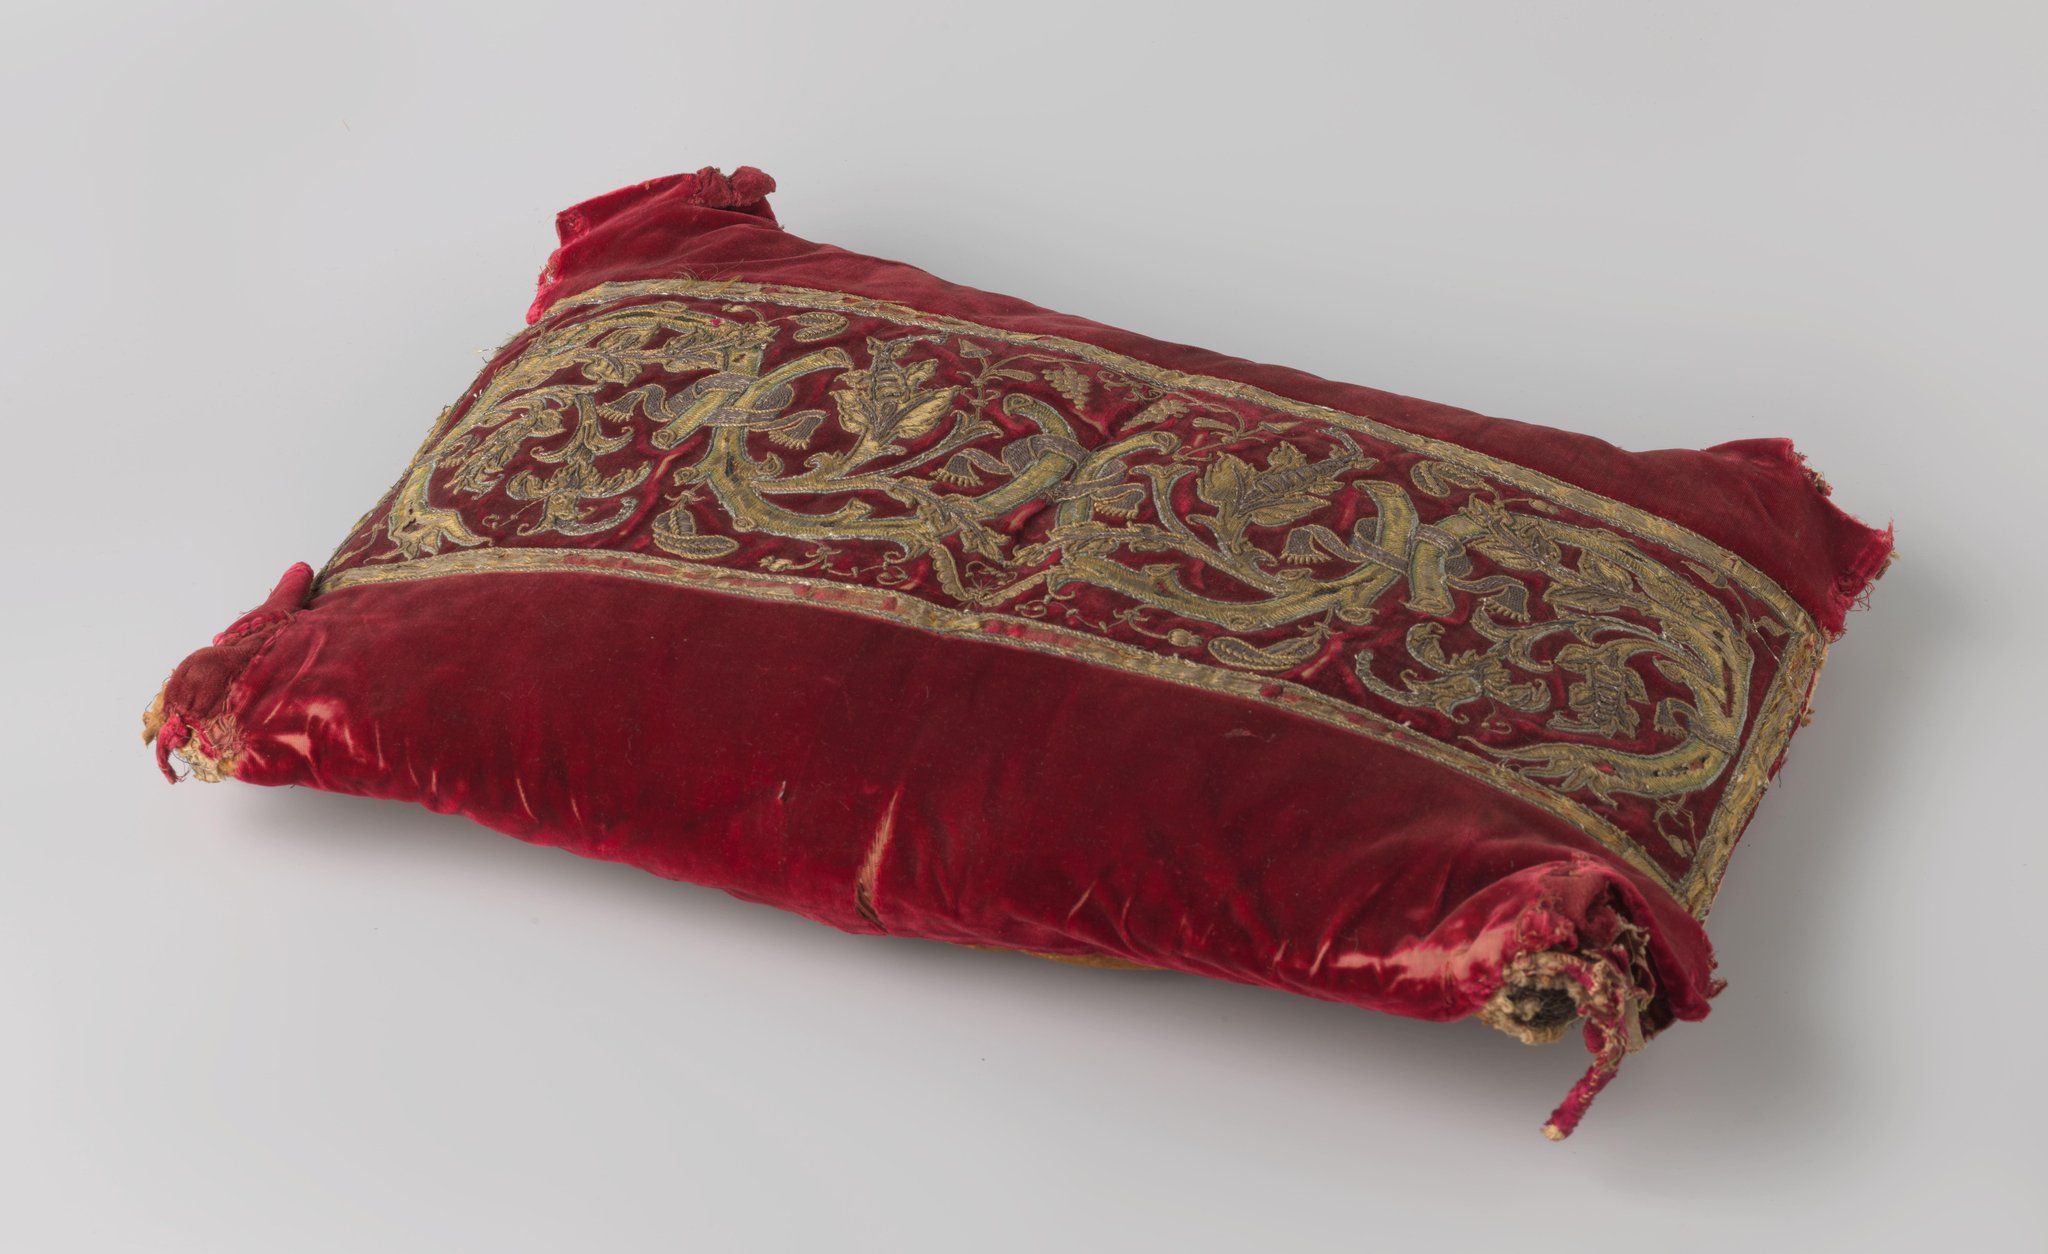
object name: top cover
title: Stoelrug van wijnrood fluweel met applicatie-borduurwerk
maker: Anonymous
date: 1500-1599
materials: thread, velvet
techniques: brocade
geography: italy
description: Stoelrug van wijnrood fluweel met applicatie-borduurwerk. Aan de korte zijden staan afgeknotte takken omwonden door een lint. Zijtakken met acanthusblad en eindigend in lelie, eikels, korenaar en druiventrossen. Applicatie van goudbrokaat geborduurd met groene en gele zijde. Langs de contouren glegd goud en blauw koord. Bladnerven van zilverdraad.